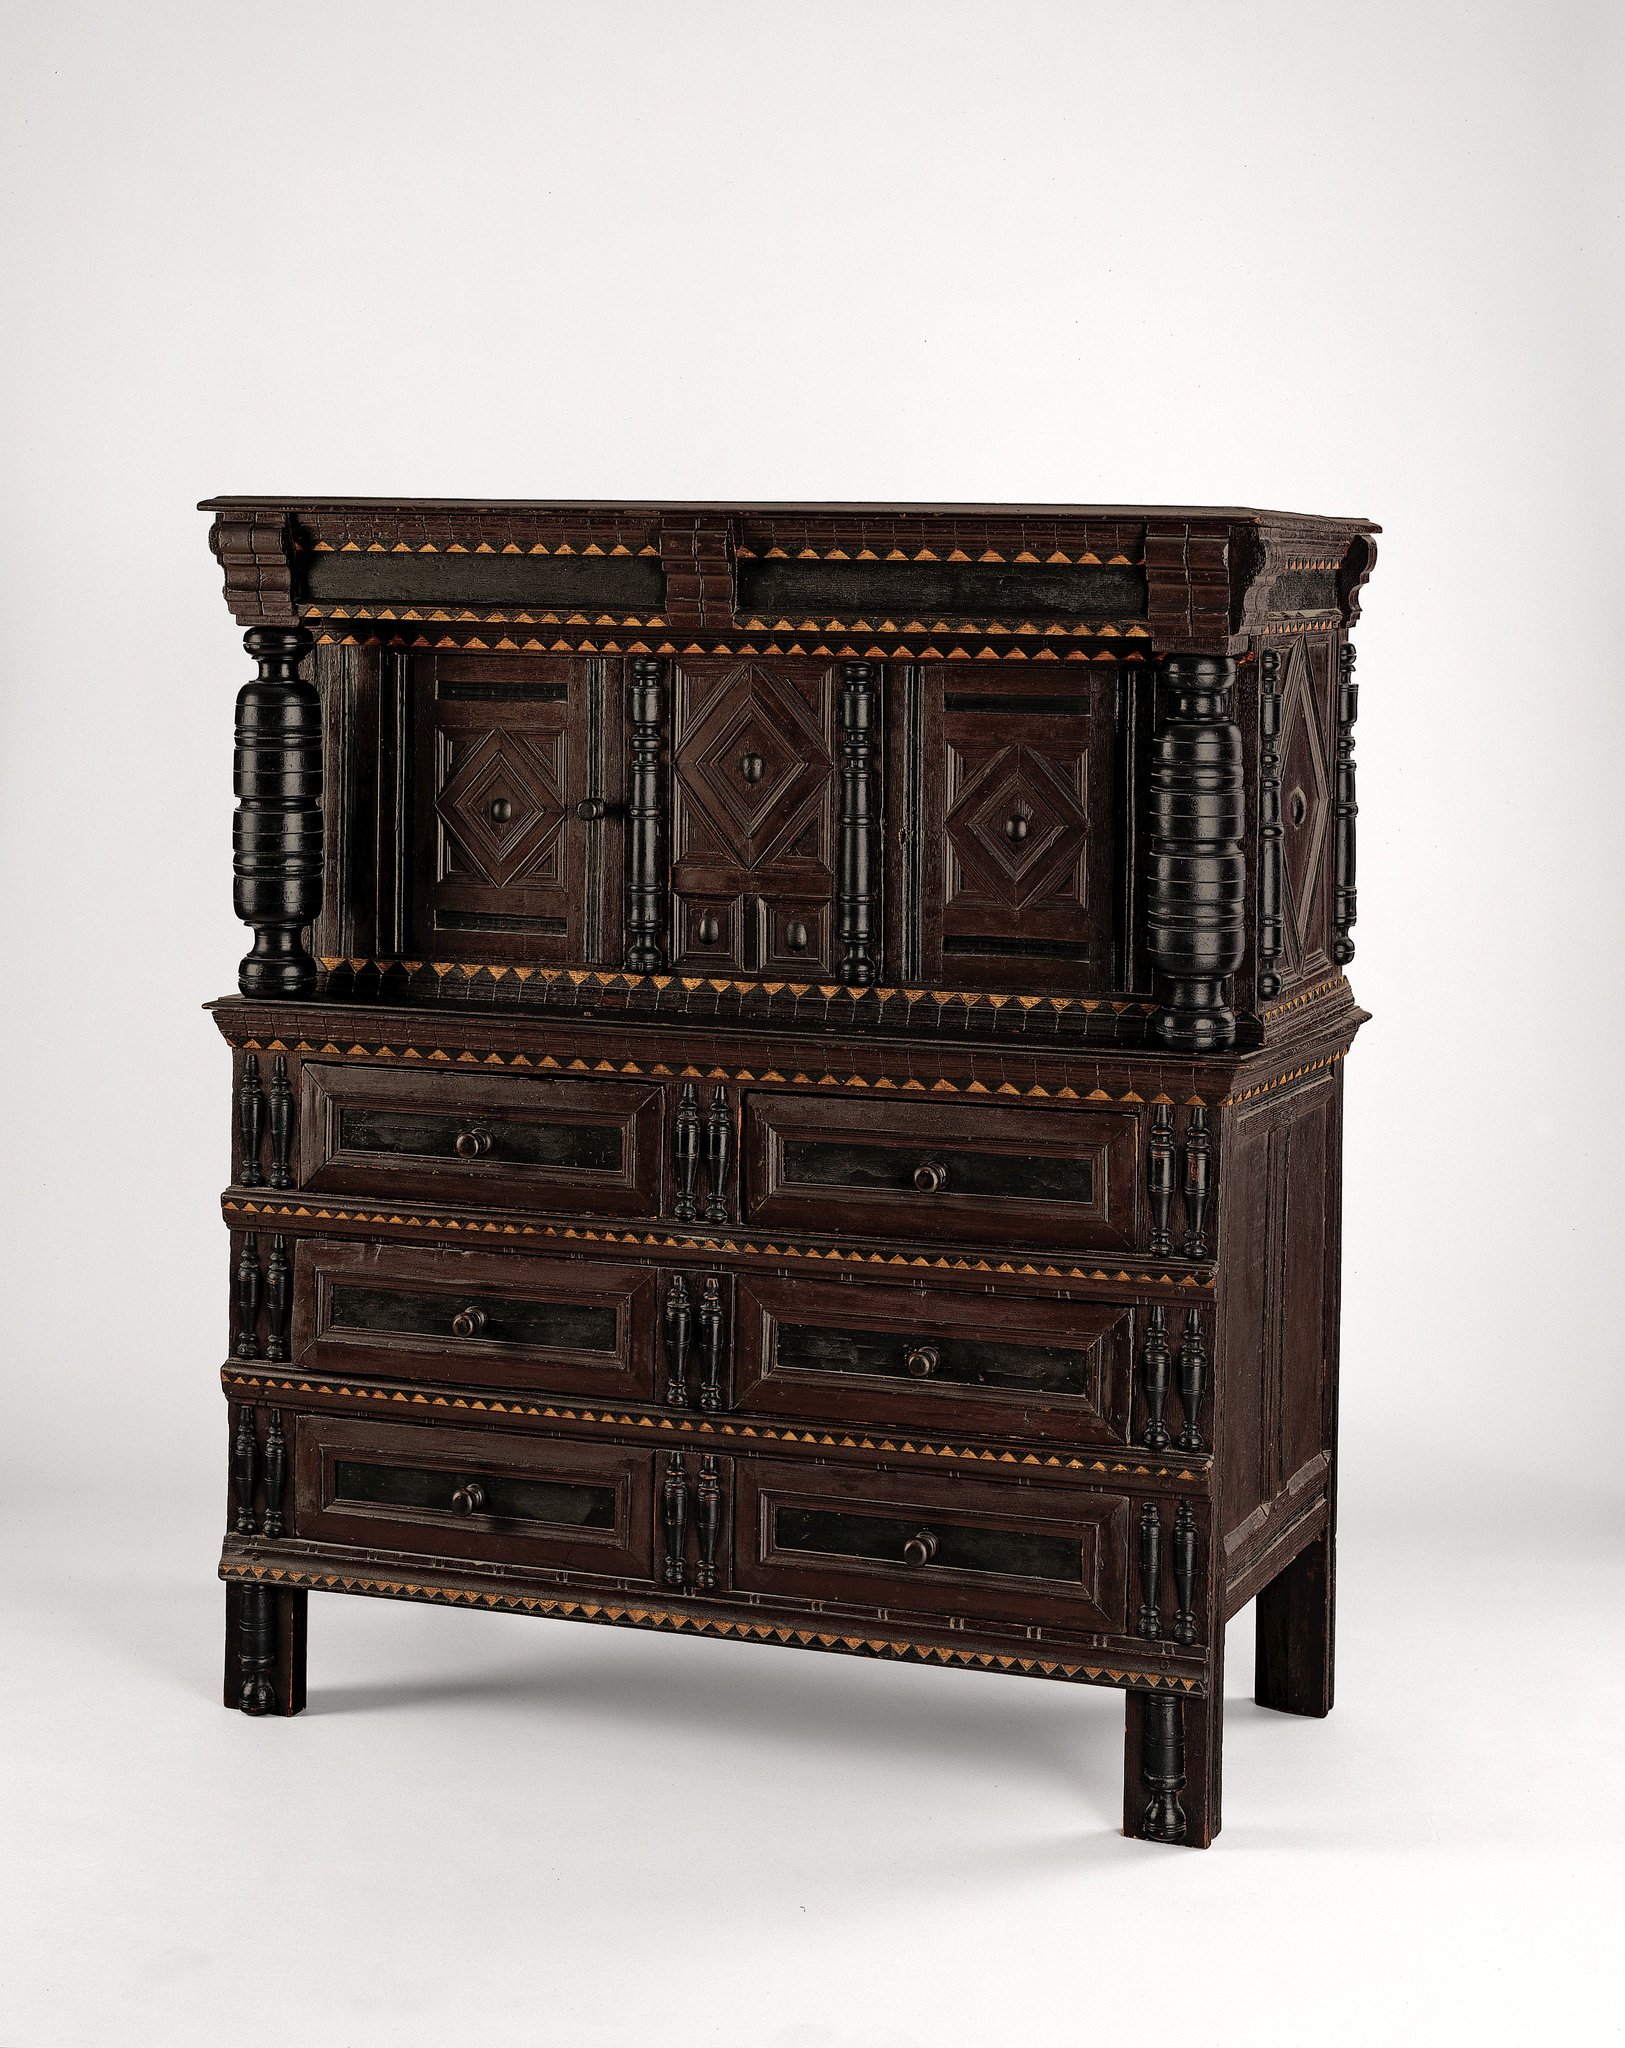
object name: cupboard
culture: american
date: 1670-1700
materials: wood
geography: united states